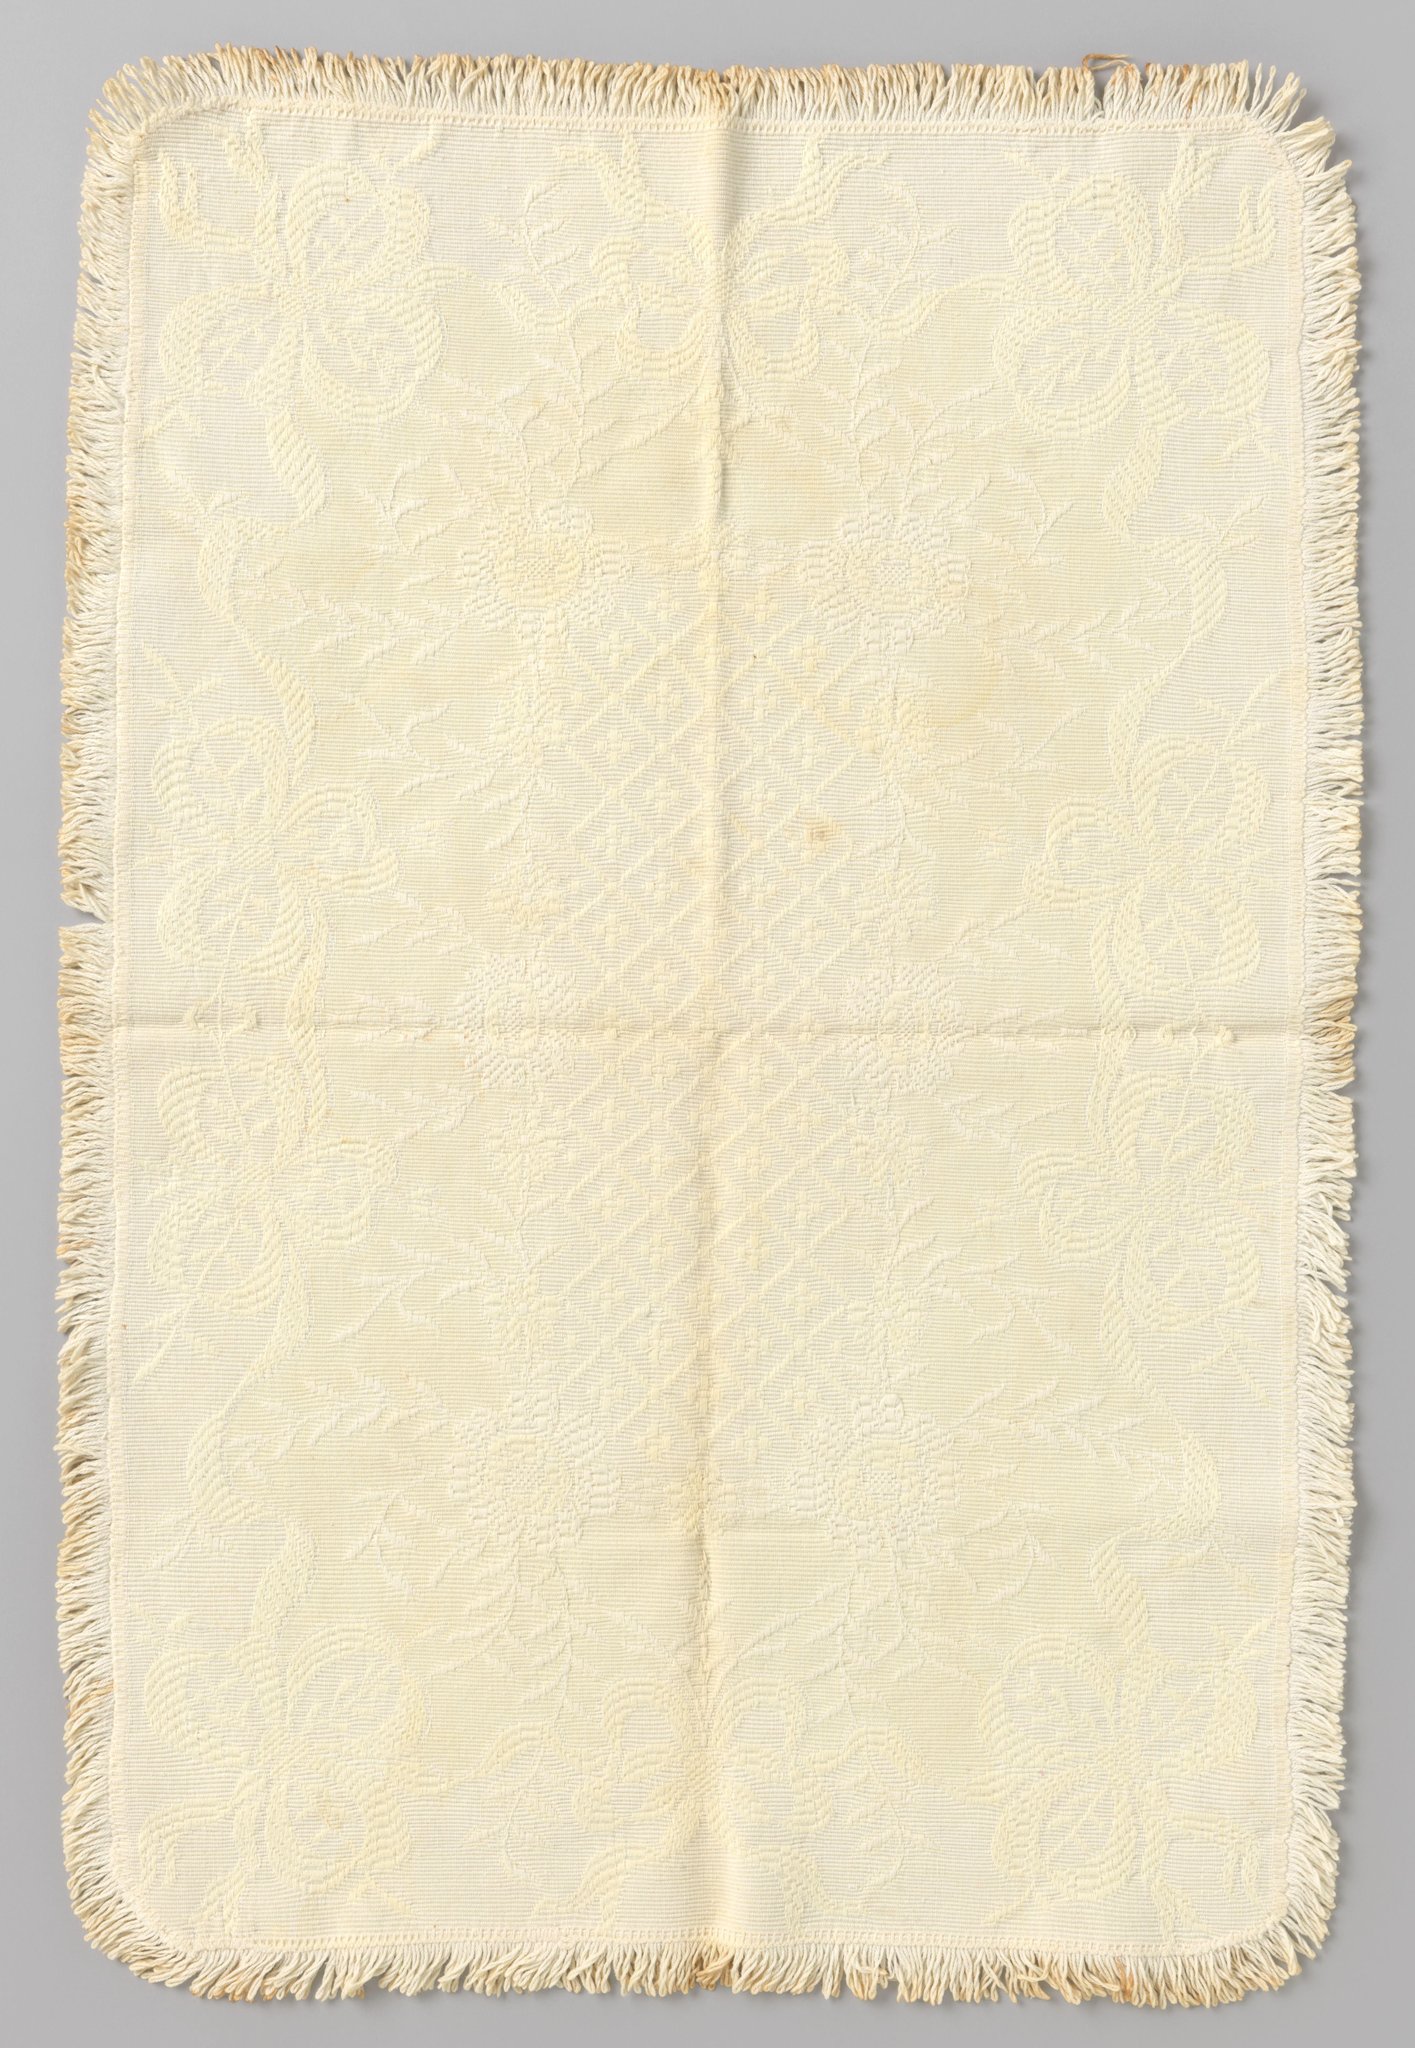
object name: bed covering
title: Wiegensprei of kinderwagensprei van grove ripskatoen, met klaverbladeren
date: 1890-1910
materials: cotton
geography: netherlands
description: Wiegensprei of kinderwagensprei van grove ripskatoen, met klaverbladeren.